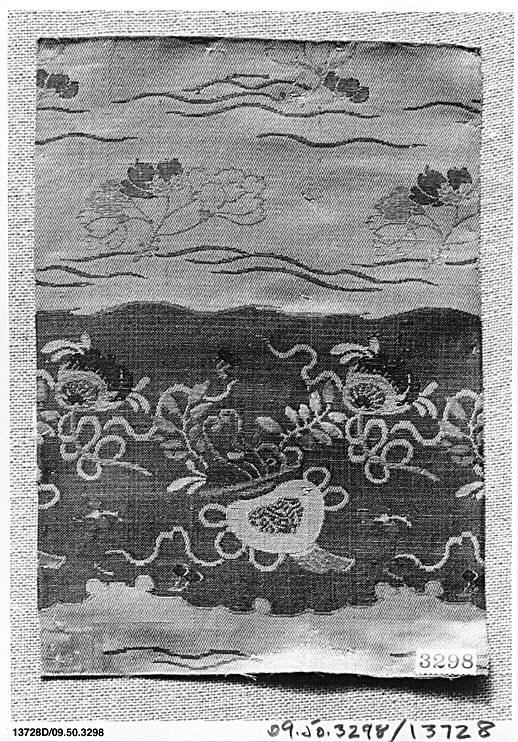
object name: piece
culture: japanese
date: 1867-1900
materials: metal thread, silk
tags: leaves